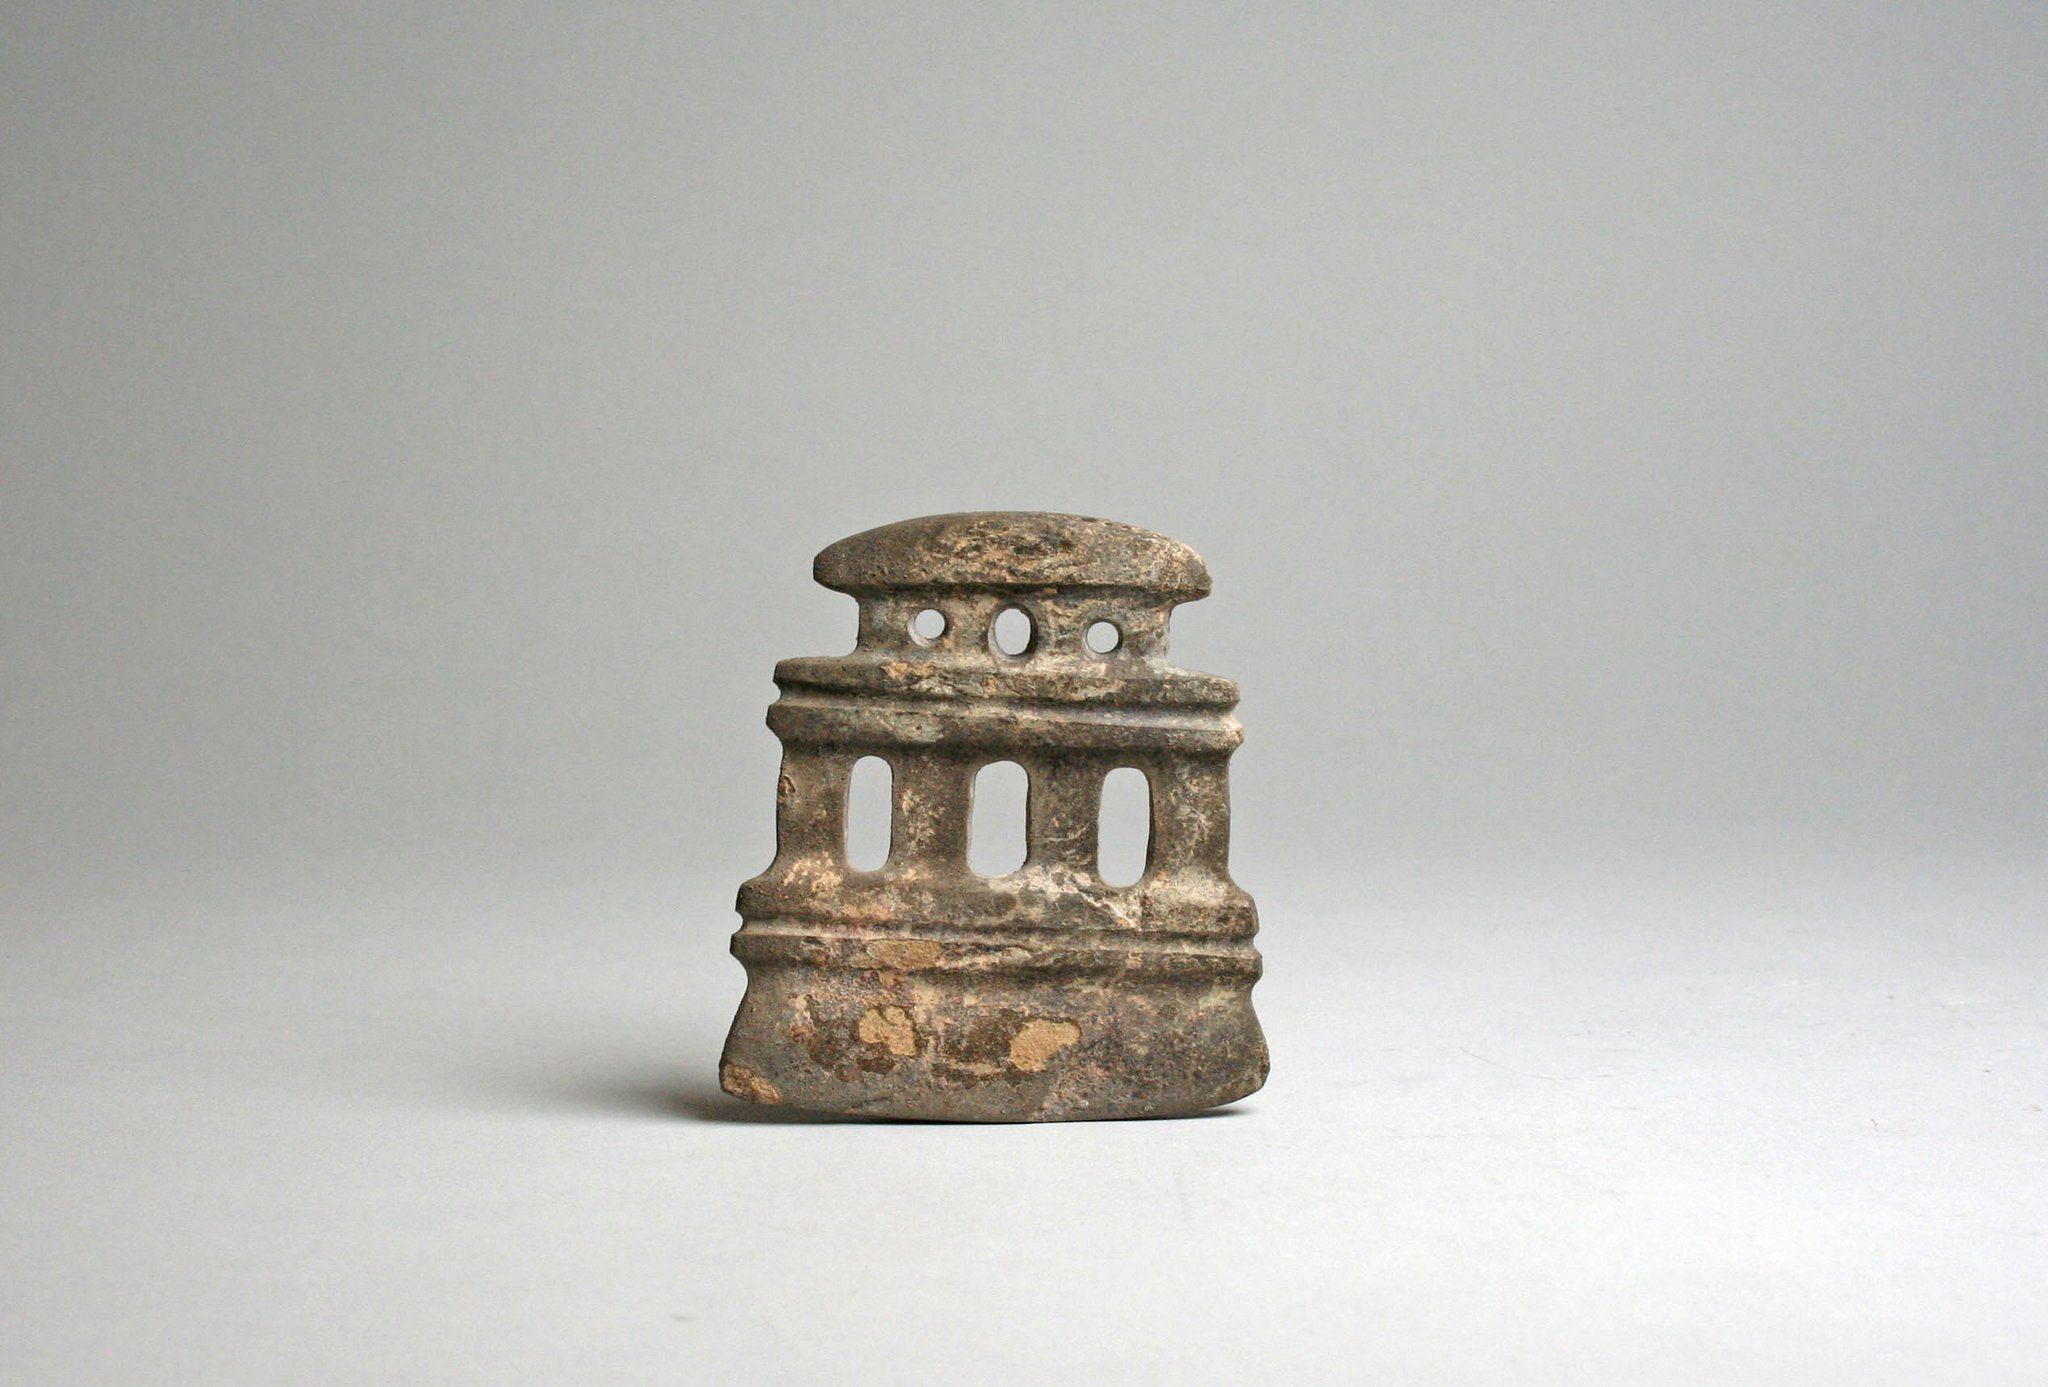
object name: architectural model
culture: mezcala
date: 1-800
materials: stone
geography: mexico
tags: temples